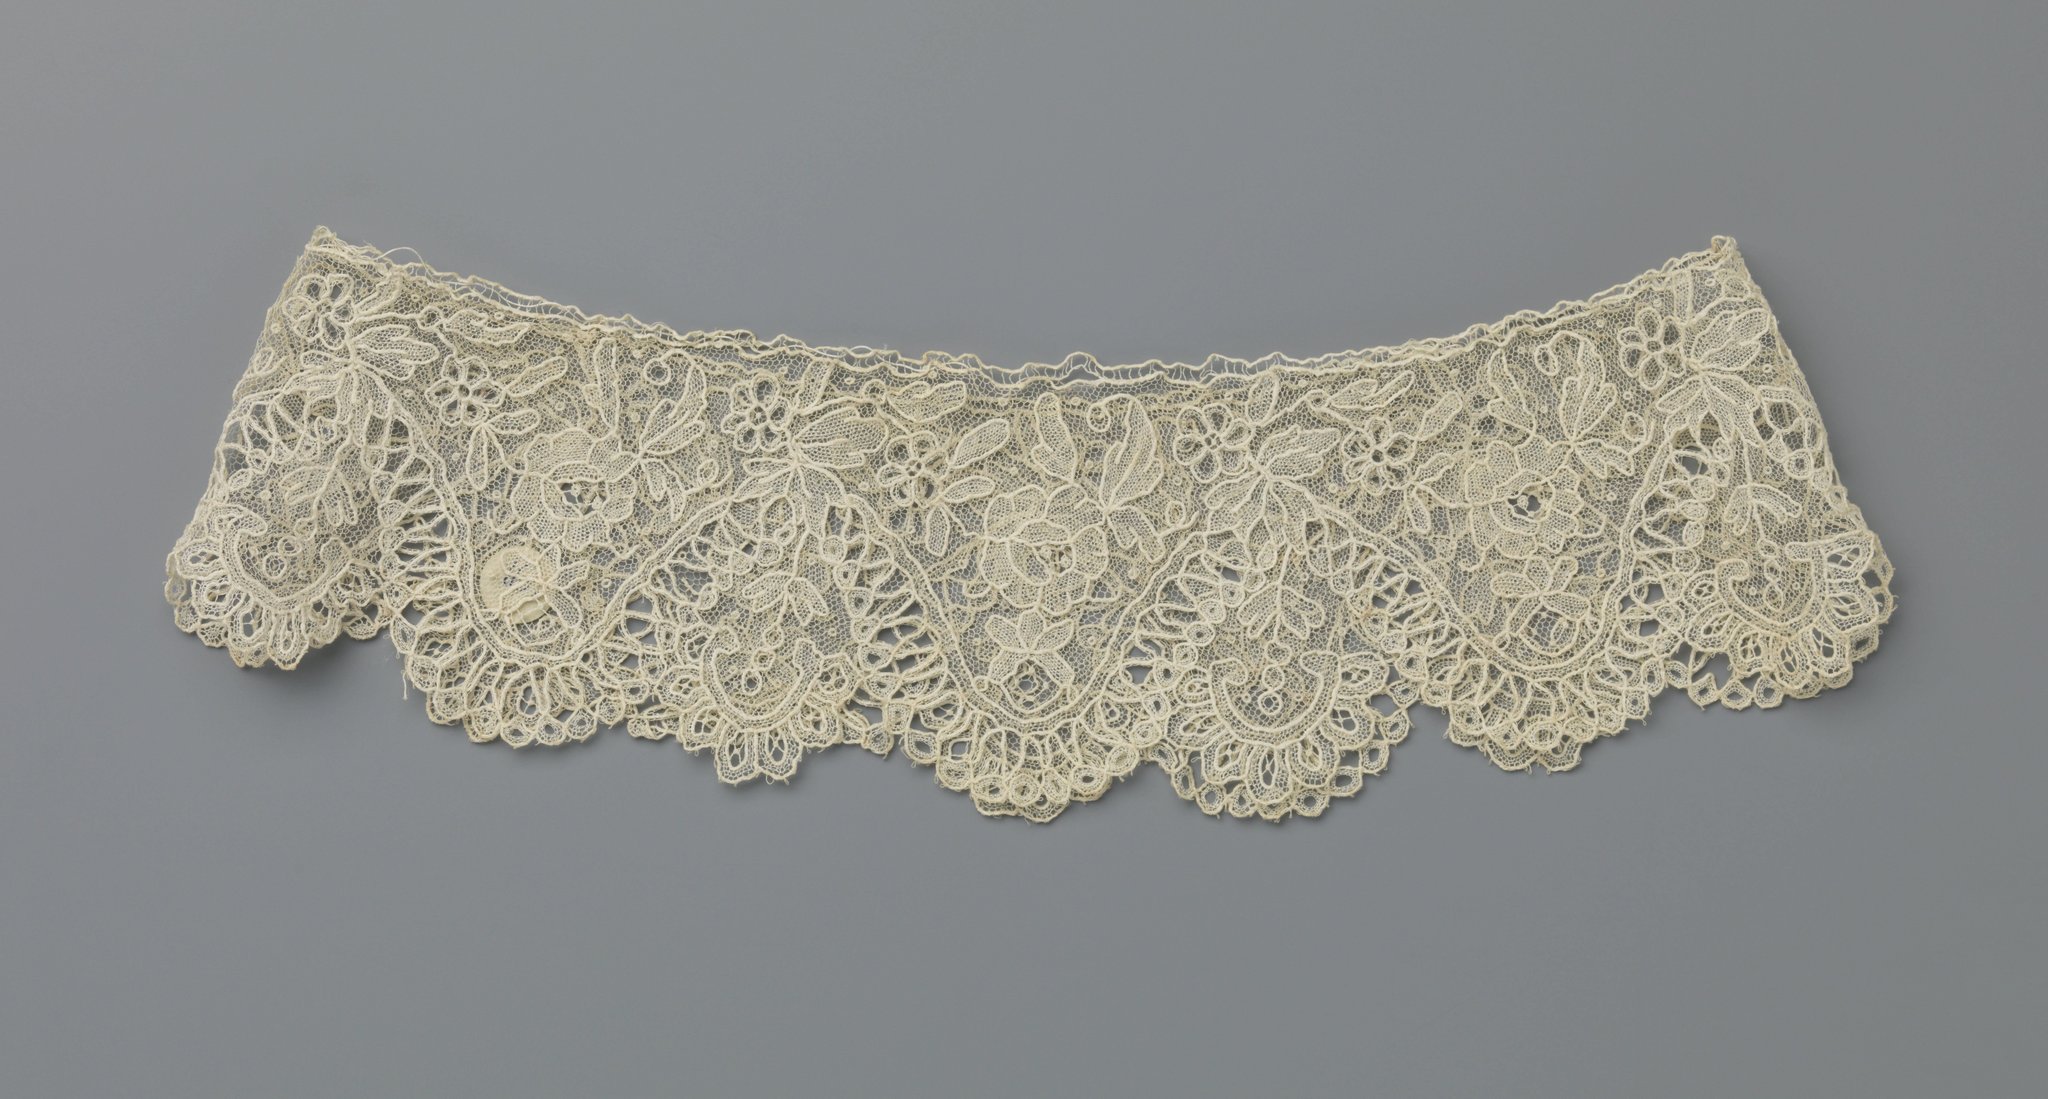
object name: cuff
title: Manchet van naaldkant met golvende zigzag-sierlijst en rozentak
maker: Anonymous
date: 1900-1924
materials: linen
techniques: lace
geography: hirschberg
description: Manchet van naturelkleurige naaldkant: Brusselse gaaskant. Het zich herhalende patroon bestaat uit een regelmatig golvende sierlijst, met in elk dal een rozentak. Aan de rozentak zit één grote roos in het centrum waaronder een kleinere roos hangt, aan de dunne tak die richting top gaat nog twee opengewerkte rozetbloemen. Onder elke golftop hangt een halfcirkelvormige bloem aan een dunne steel met twee hartvormige blaadjes. De bloem bestaat uit een liggende c-voluut met zeven lobben als bloemblaadjes. De golvende sierlijst bestaat uit twee dicht op elkaar geplaatste contourdraden die een smalle lijn vormen en waaronder een sterk slingerende contourdraad hangt, die voor een open zigzag-lijn zorgt. Onder de open zigzag een aaneenschakeling van cirkeltjes. De golvende sierlijst vormt de schulpenrand, samen met de hangende cirkelvormige bloem. De aaneengeschakelde cirkeltjes en zeven bloemblaadjes zorgen voor de lobjes aan de schulpenrand. De motieven zijn voorzien van dikke contourdraden en zijn met elkaar verbonden door een fijne maasgrond, een gaaskantgrond, met moesjes. Enkele siersteken zijn toegepast in de bloemharten van de rozen en in de bloemblaadjes van de hangende bloem. De bovenzijde van de strook is afgewerkt met een dubbele contourdraad. De schulpenrand is afgewerkt met zeer fijne picots.